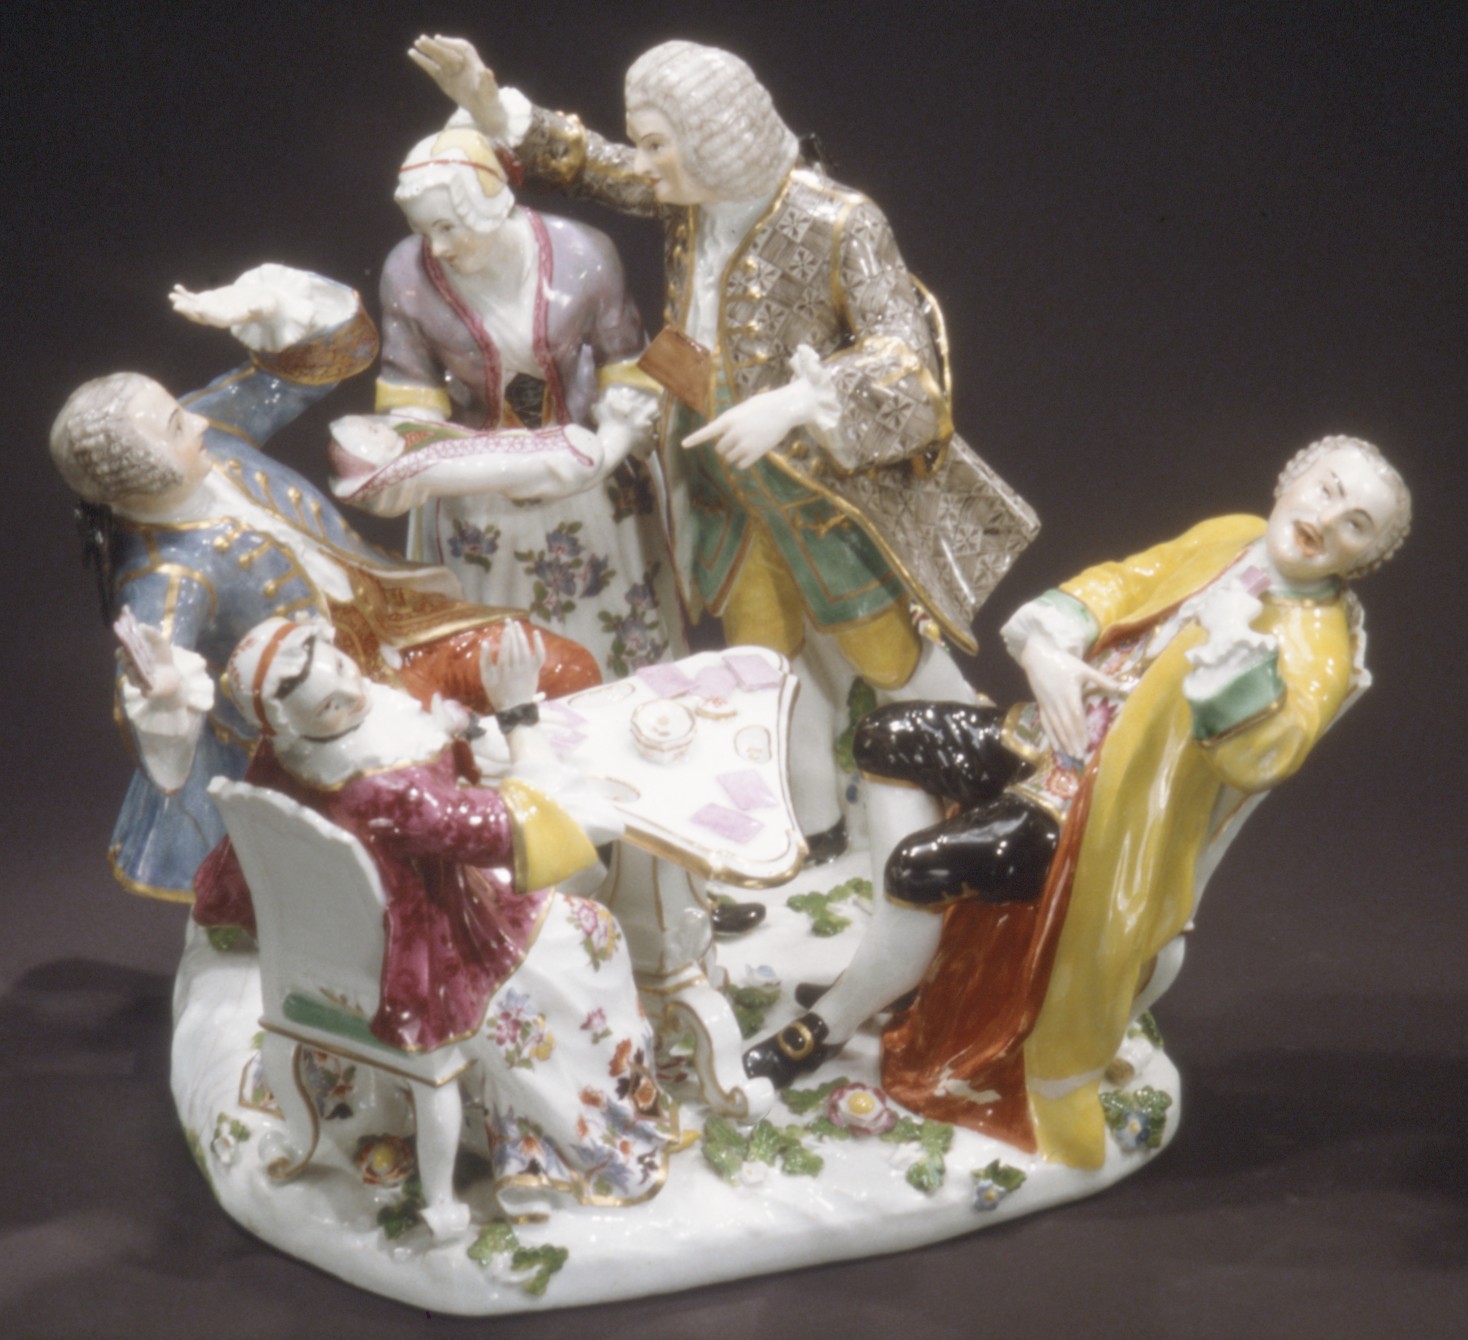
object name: figure group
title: Satirical group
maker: johann joachim kändler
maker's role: modeler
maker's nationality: german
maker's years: 1706-1775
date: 1742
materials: hard paste porcelain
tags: infants,men,women